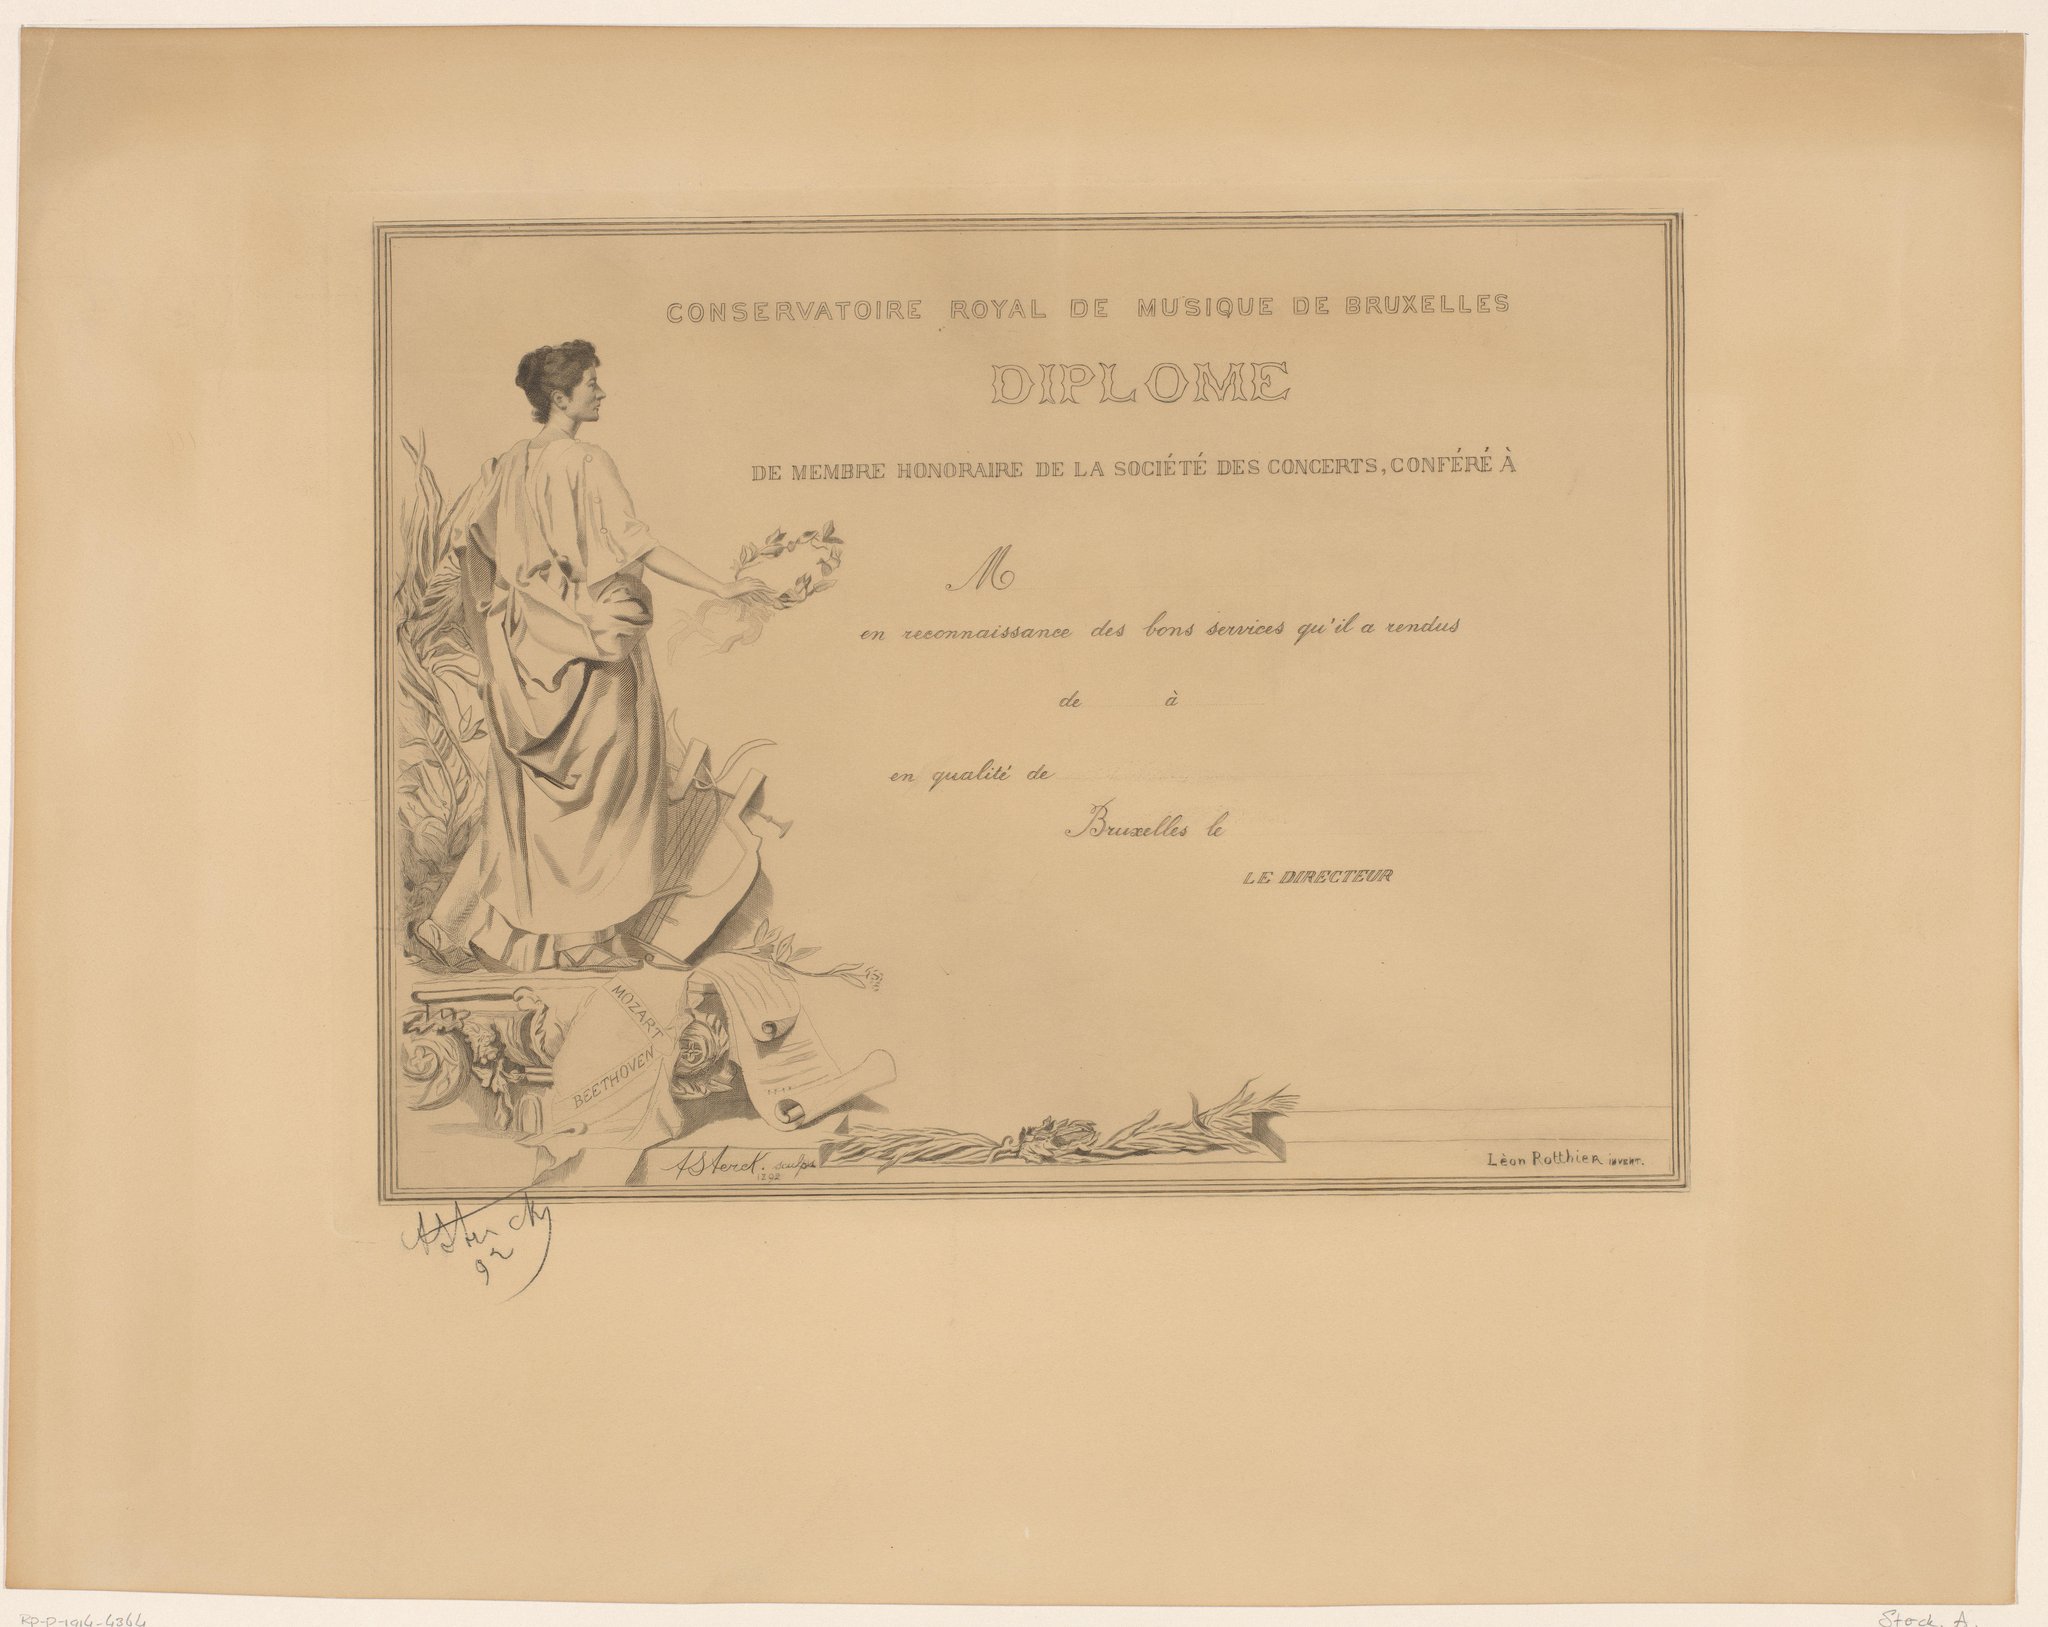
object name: print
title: Conservatiore royal de musique de Bruxelles diplome de membre honoraire de la société des concerts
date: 1892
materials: paper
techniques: etching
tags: 'musica', symbolic representations, allegories and emblems ~ music; 'musica'(ripa)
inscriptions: collector's mark: Lugt 2228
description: Oningevuld lidmaatschapsbewijs van de concertvereniging van het conservatorium in Brussel.